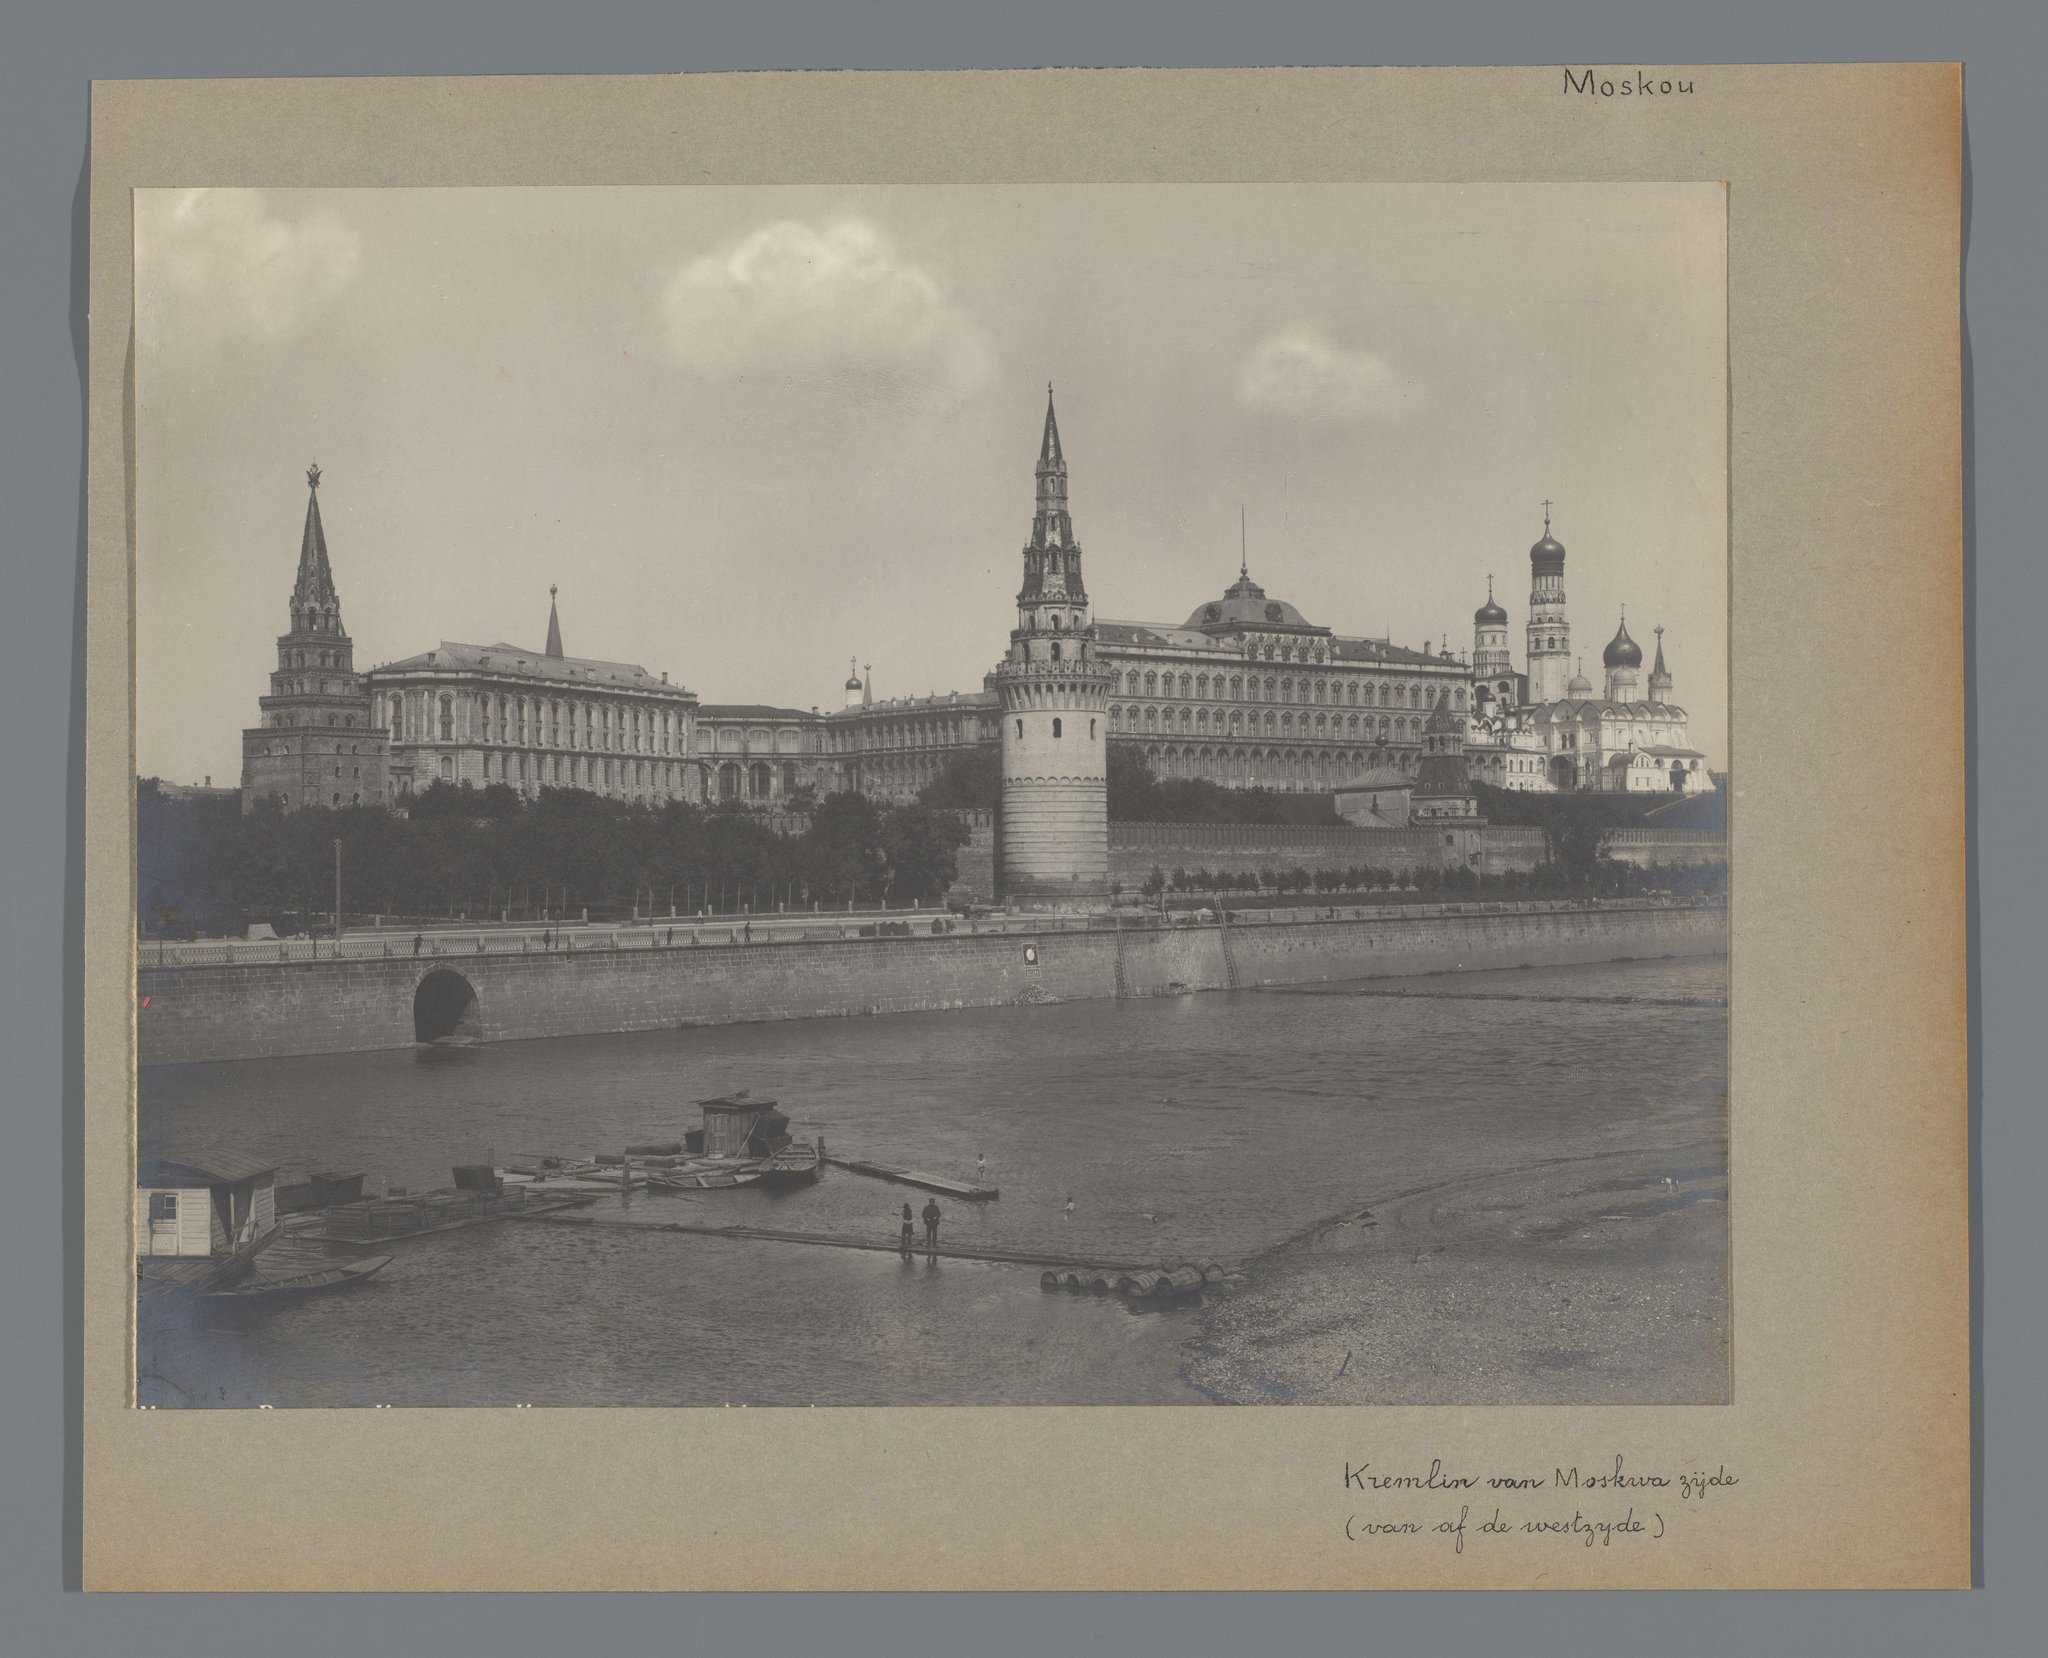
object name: photograph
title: Moskou. Kremlin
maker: Anonymous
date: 1880-1930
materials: photographic support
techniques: gelatin silver print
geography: russia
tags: kremlin